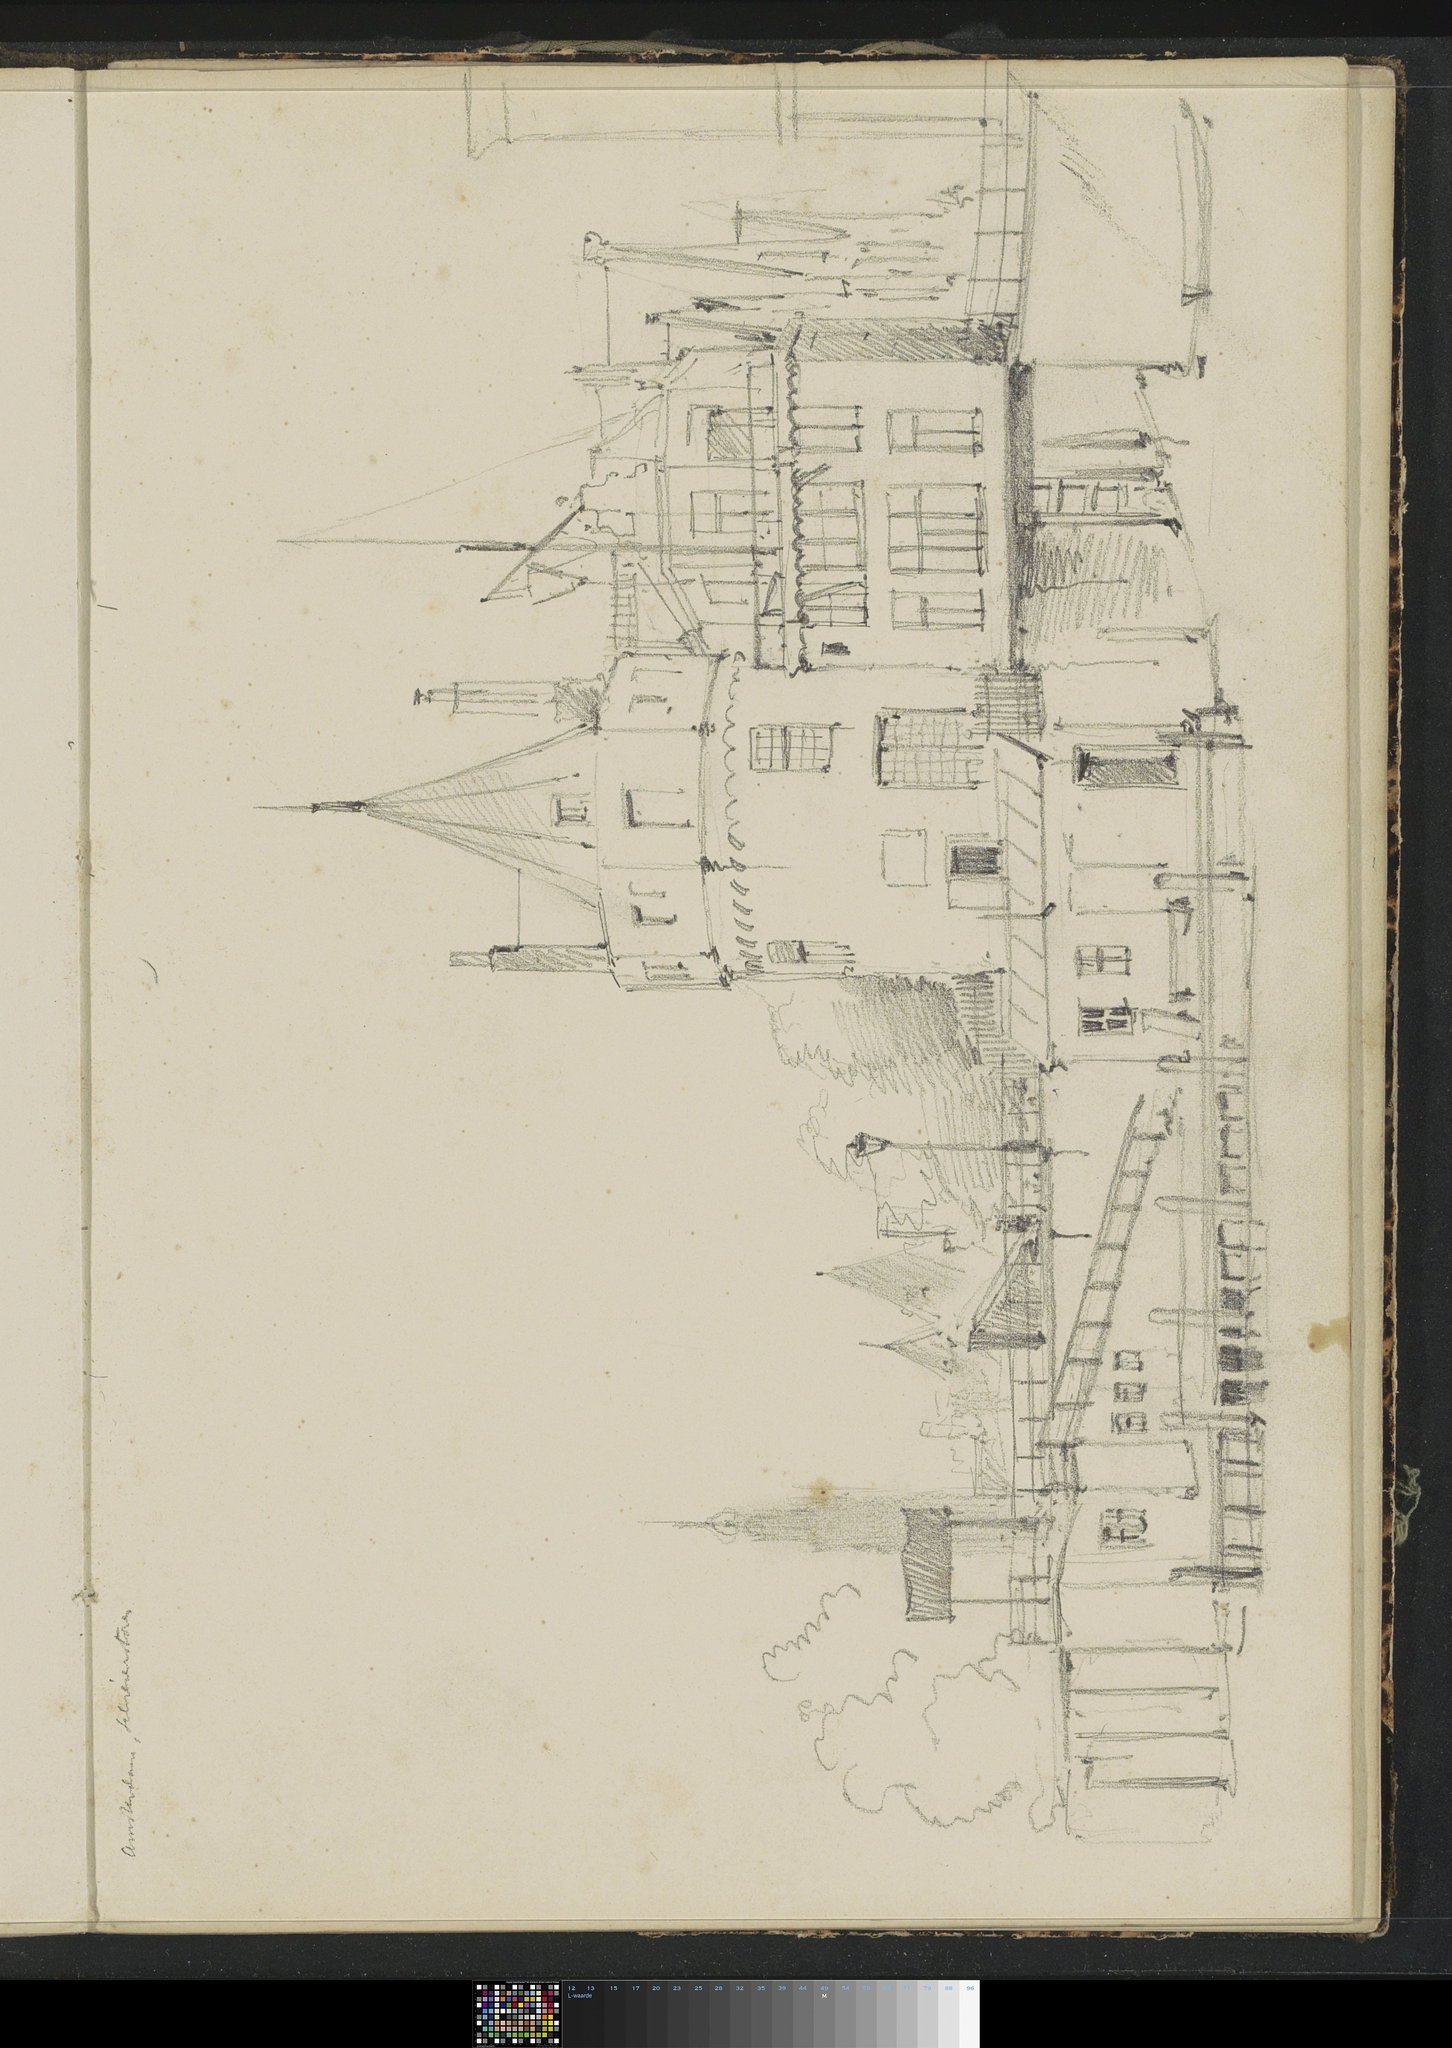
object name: sketchbook leaf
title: Gezicht op de Schreierstoren te Amsterdam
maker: willem koekkoek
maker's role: draughtsman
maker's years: 1839-1895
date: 1888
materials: paper, pencil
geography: amsterdam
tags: towers ~ fortified city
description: Blad 11 recto uit een schetsboek met 24 bladen.